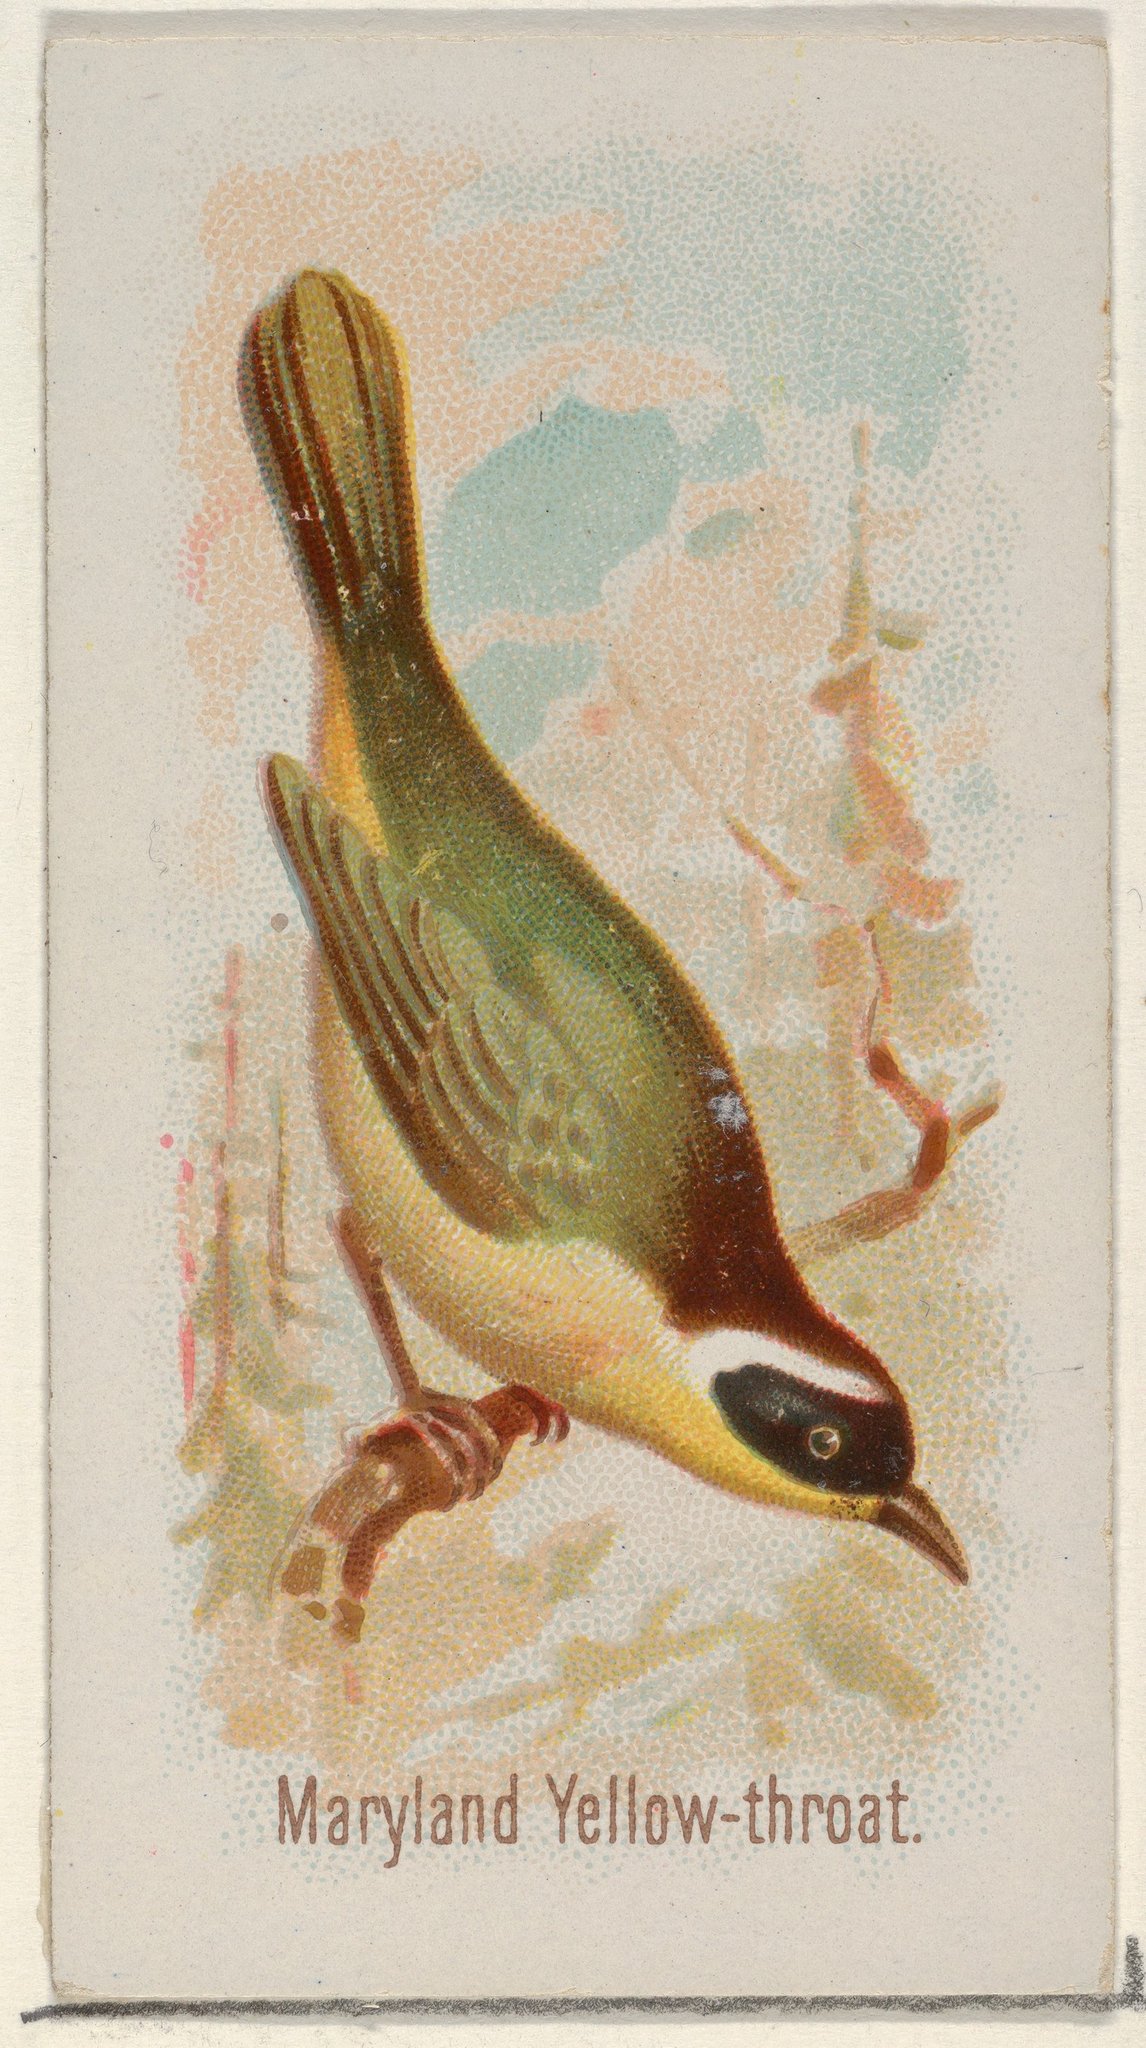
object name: print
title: Maryland Yellow-throat, from the Song Birds of the World series (N23) for Allen & Ginter Cigarettes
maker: allen & ginter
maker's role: publisher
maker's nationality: american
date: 1890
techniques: color lithograph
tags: birds